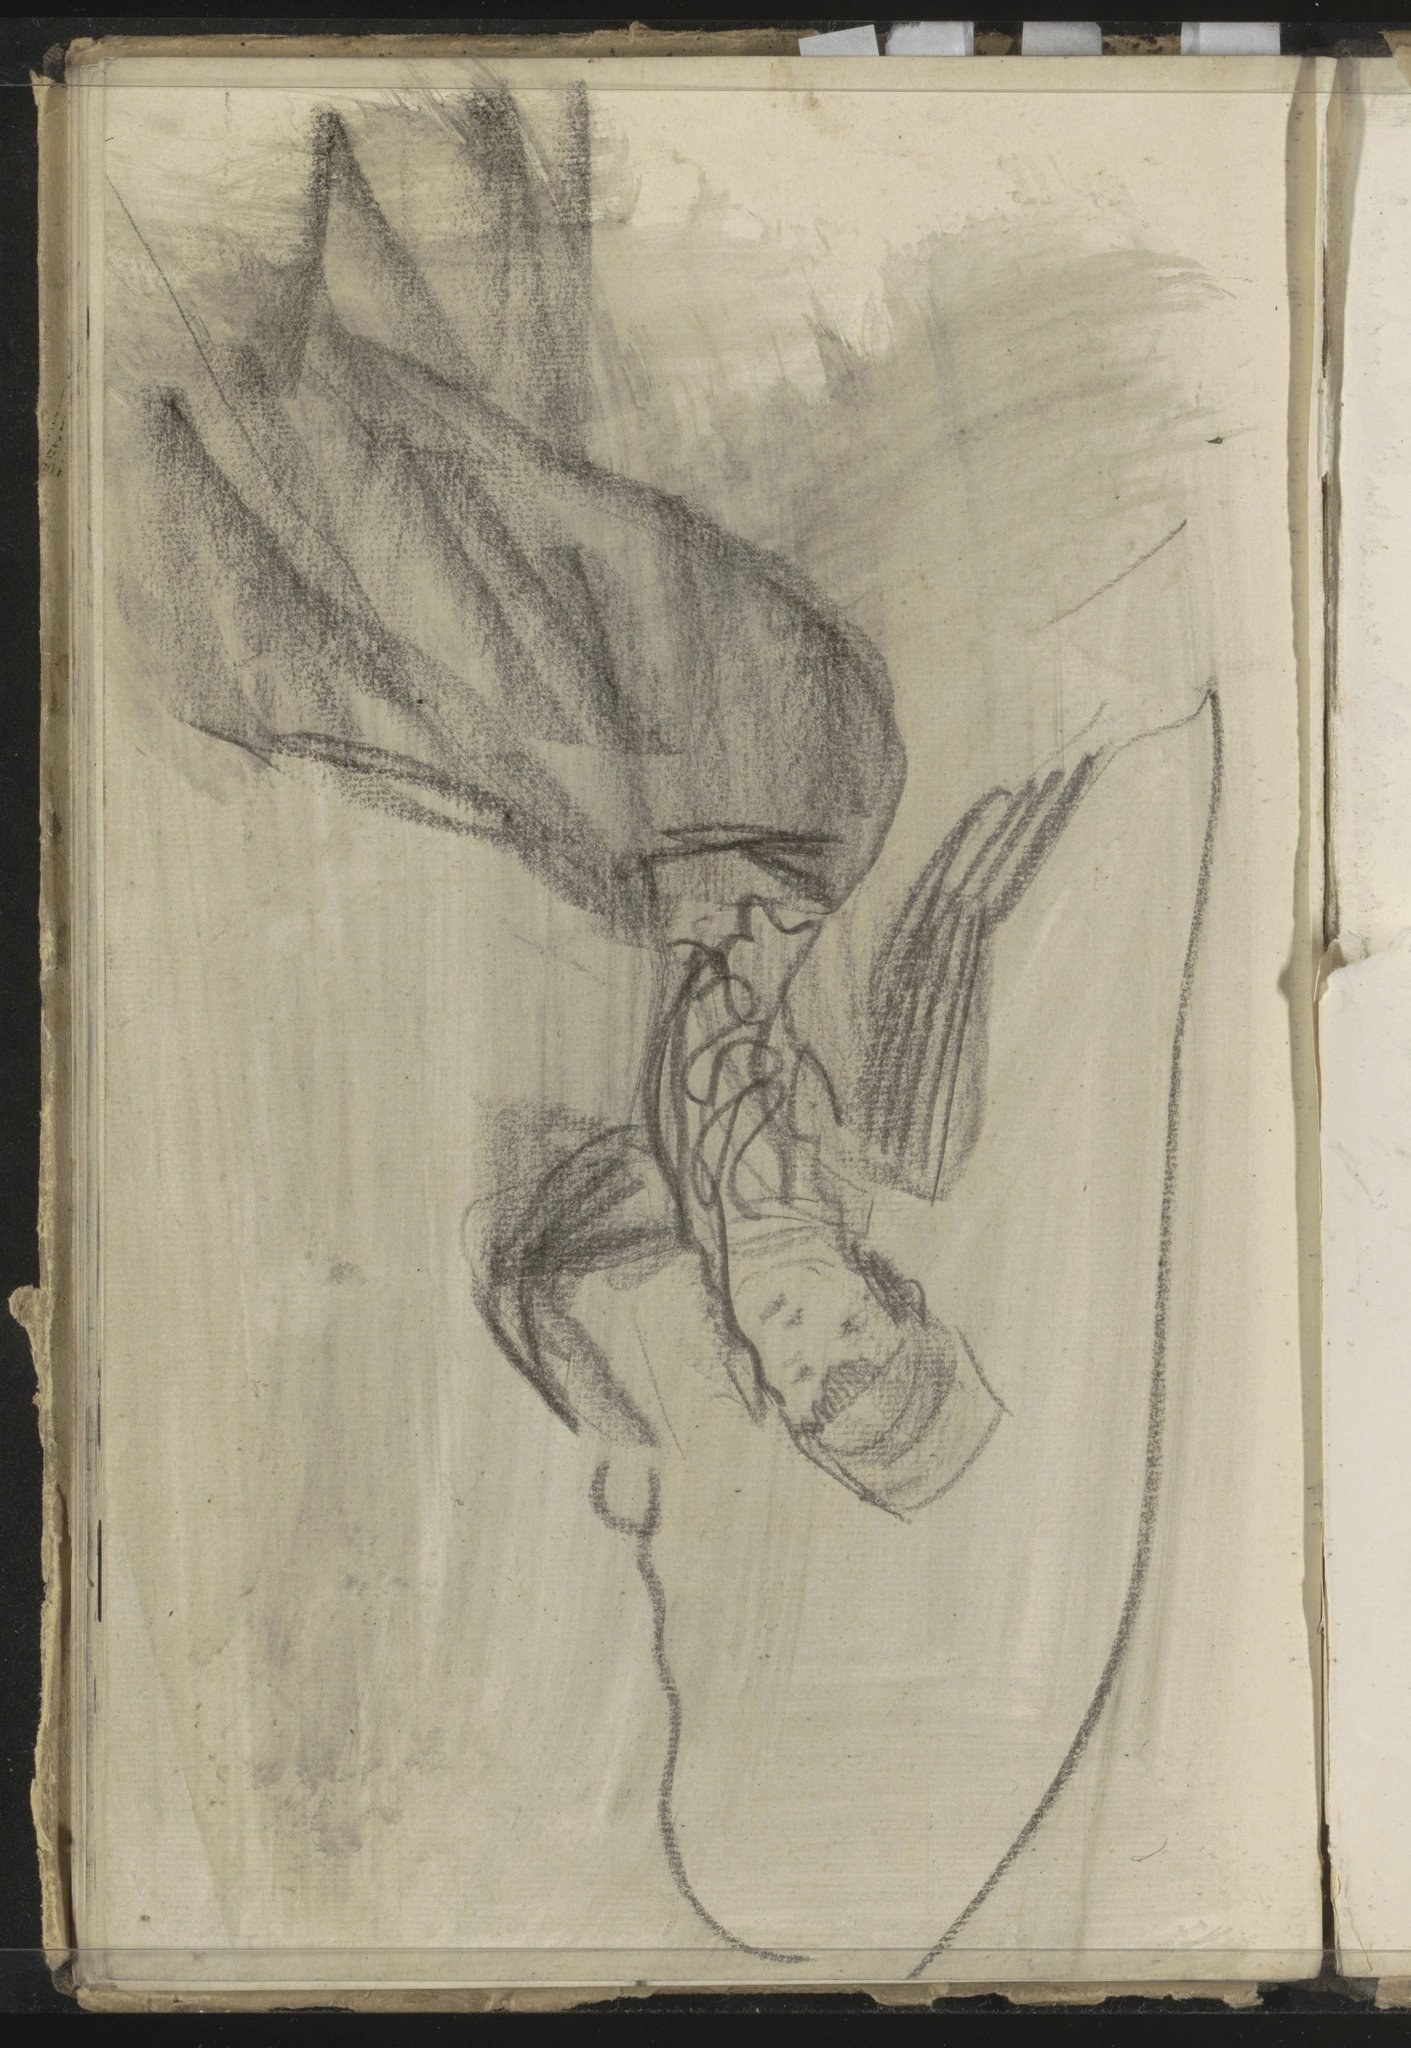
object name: sketchbook leaf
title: Zittende vrouw met een touw in haar handen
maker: carel adolph lion cachet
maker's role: draughtsman, print maker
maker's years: 1864-1945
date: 1890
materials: chalk, paper, watercolor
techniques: brush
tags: sitting figure - aa - female human figure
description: Mogelijk een springtouw. Blad 37 verso uit een schetsboek met 38 bladen.